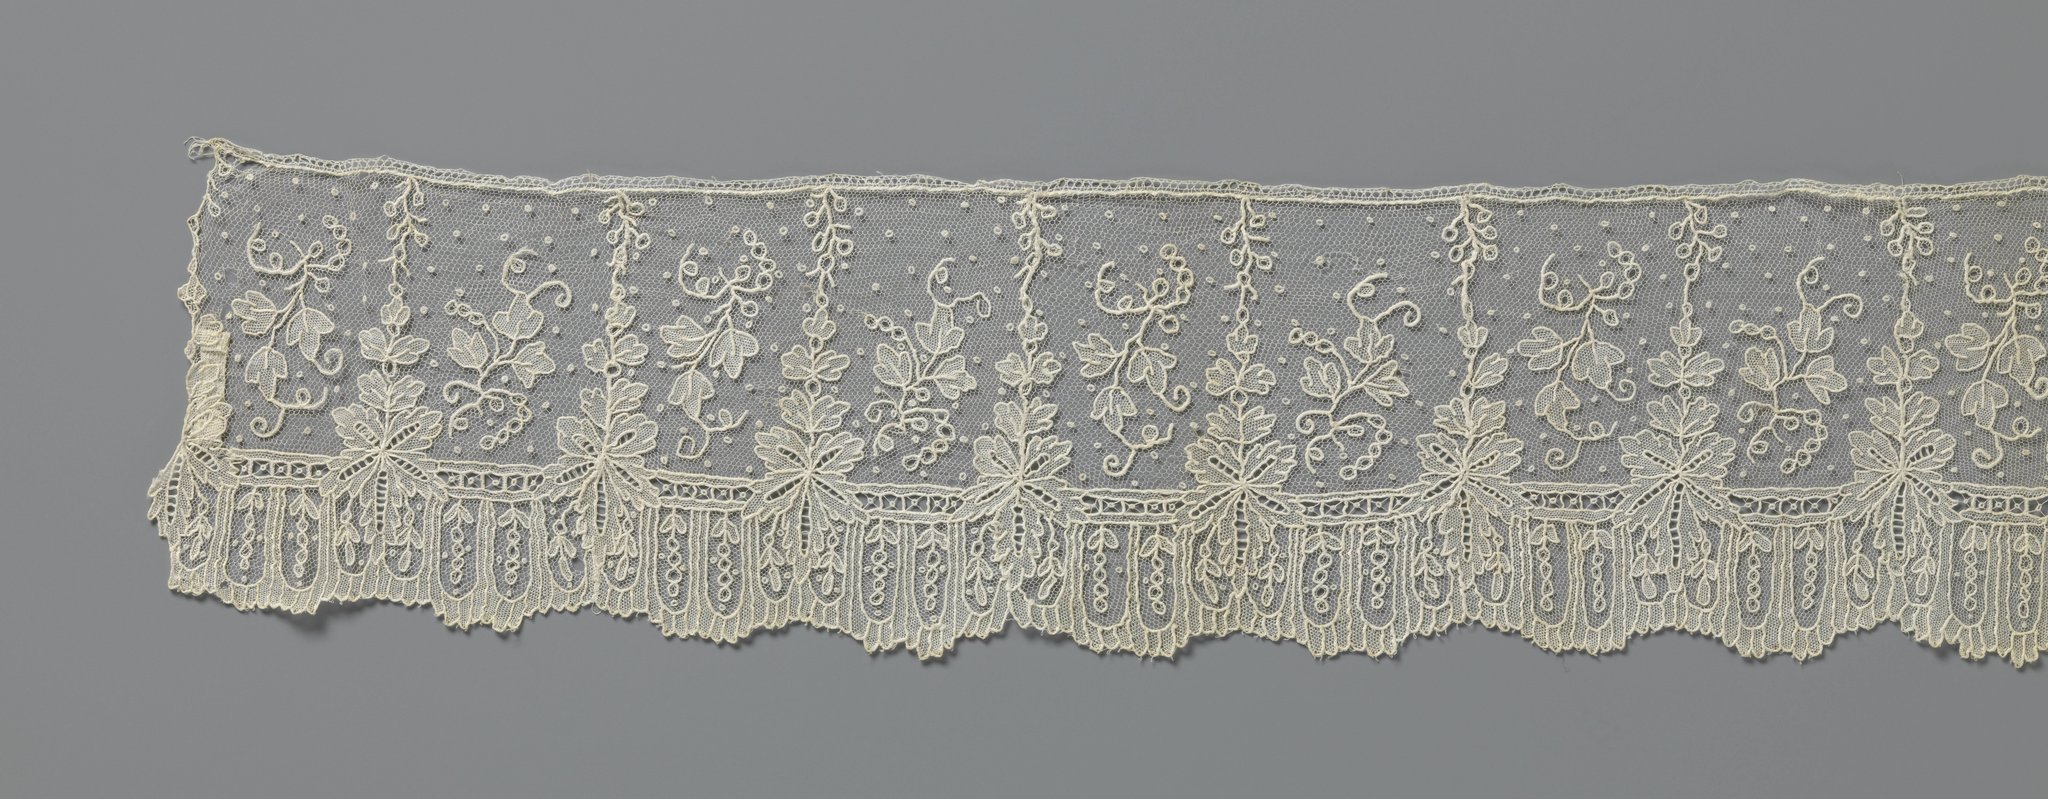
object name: strip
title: Strook naaldkant met bladranken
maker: Anonymous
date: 1875-1899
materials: linen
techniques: needle lace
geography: brussels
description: Strook naturelkleurig naaldkant, point de gaze de Bruxelles. Repetitief motief met verticale bladranken op een op een fijne grond met enkelvoudige gedraaide mazen, die met enkele moesjes is bezaaid. Geschulpte onderzijde. De bovenzijde is afgezet met een rand kloskant.